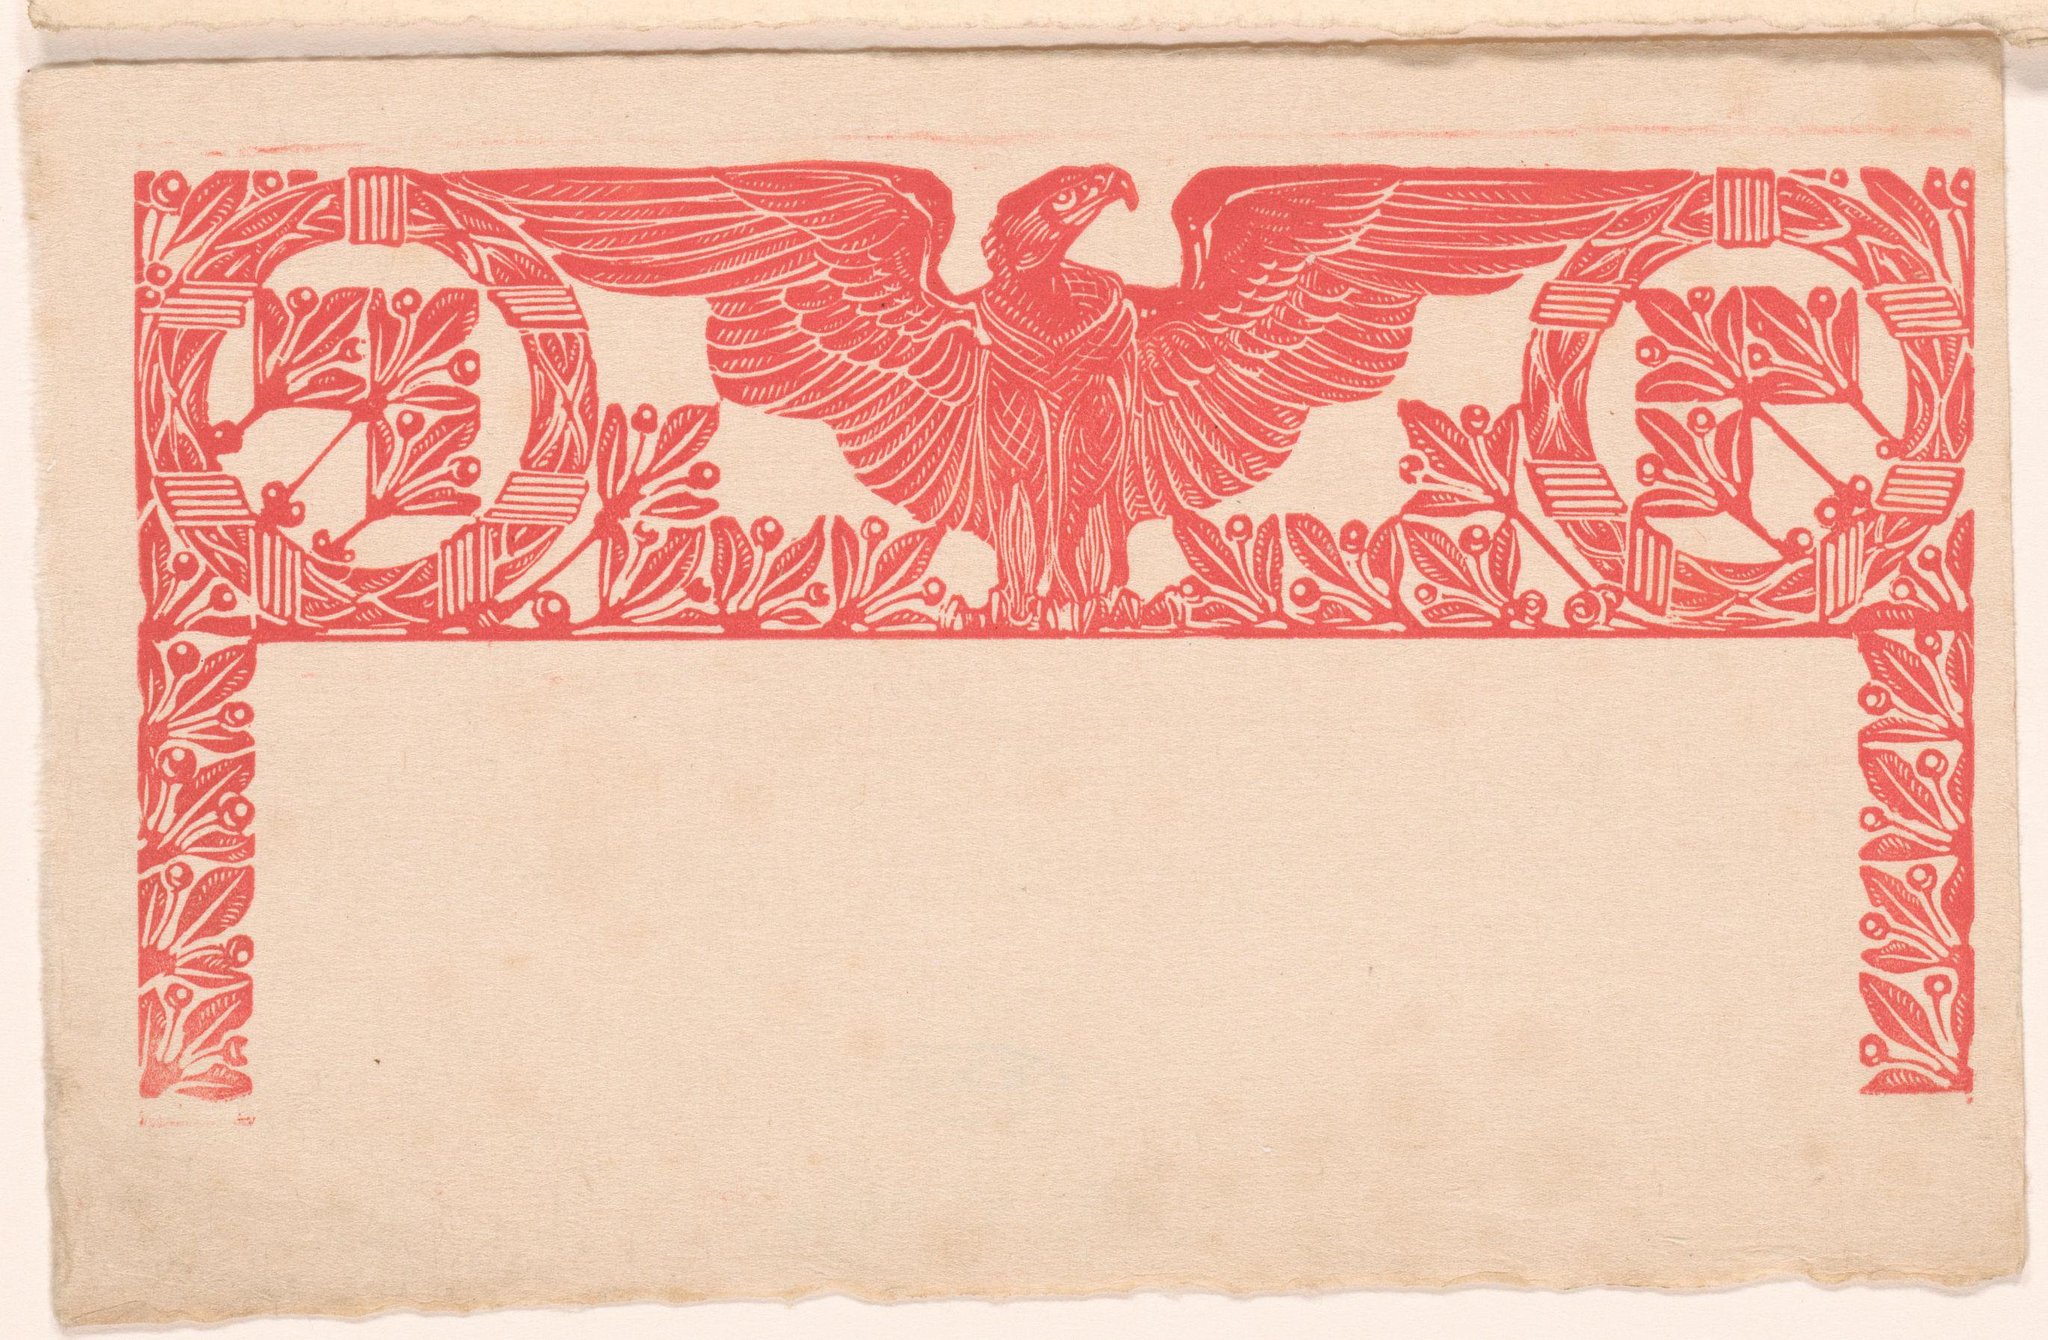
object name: boekillustratie ontwerp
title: Ornamentele rand met bladeren en adelaar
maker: bernard willem wierink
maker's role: draughtsman, print maker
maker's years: 1856-1939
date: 1910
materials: paper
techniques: relief print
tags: predatory birds: eagle, fable of reynard the fox, foliage, tendrils, branches ~ ornament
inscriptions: collector's mark: Lugt 2228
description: Ontwerp voor: Streuvels, Stijn (Frank Lateur). Reinaert de Vos naar verschillende uitgaven van het middeleeuwsche epos. Amsterdam: L.J. Veen, 1910. Deze prent is vermoedelijk een plaatsnede, ook al wordt in de literatuur veelal gesproken over een houtsnede. Voor zover Wierink zijn prenten in hoogdruk zelf nader heeft omschreven, heeft hij altijd de term 'plaatsnede' gebruikt.